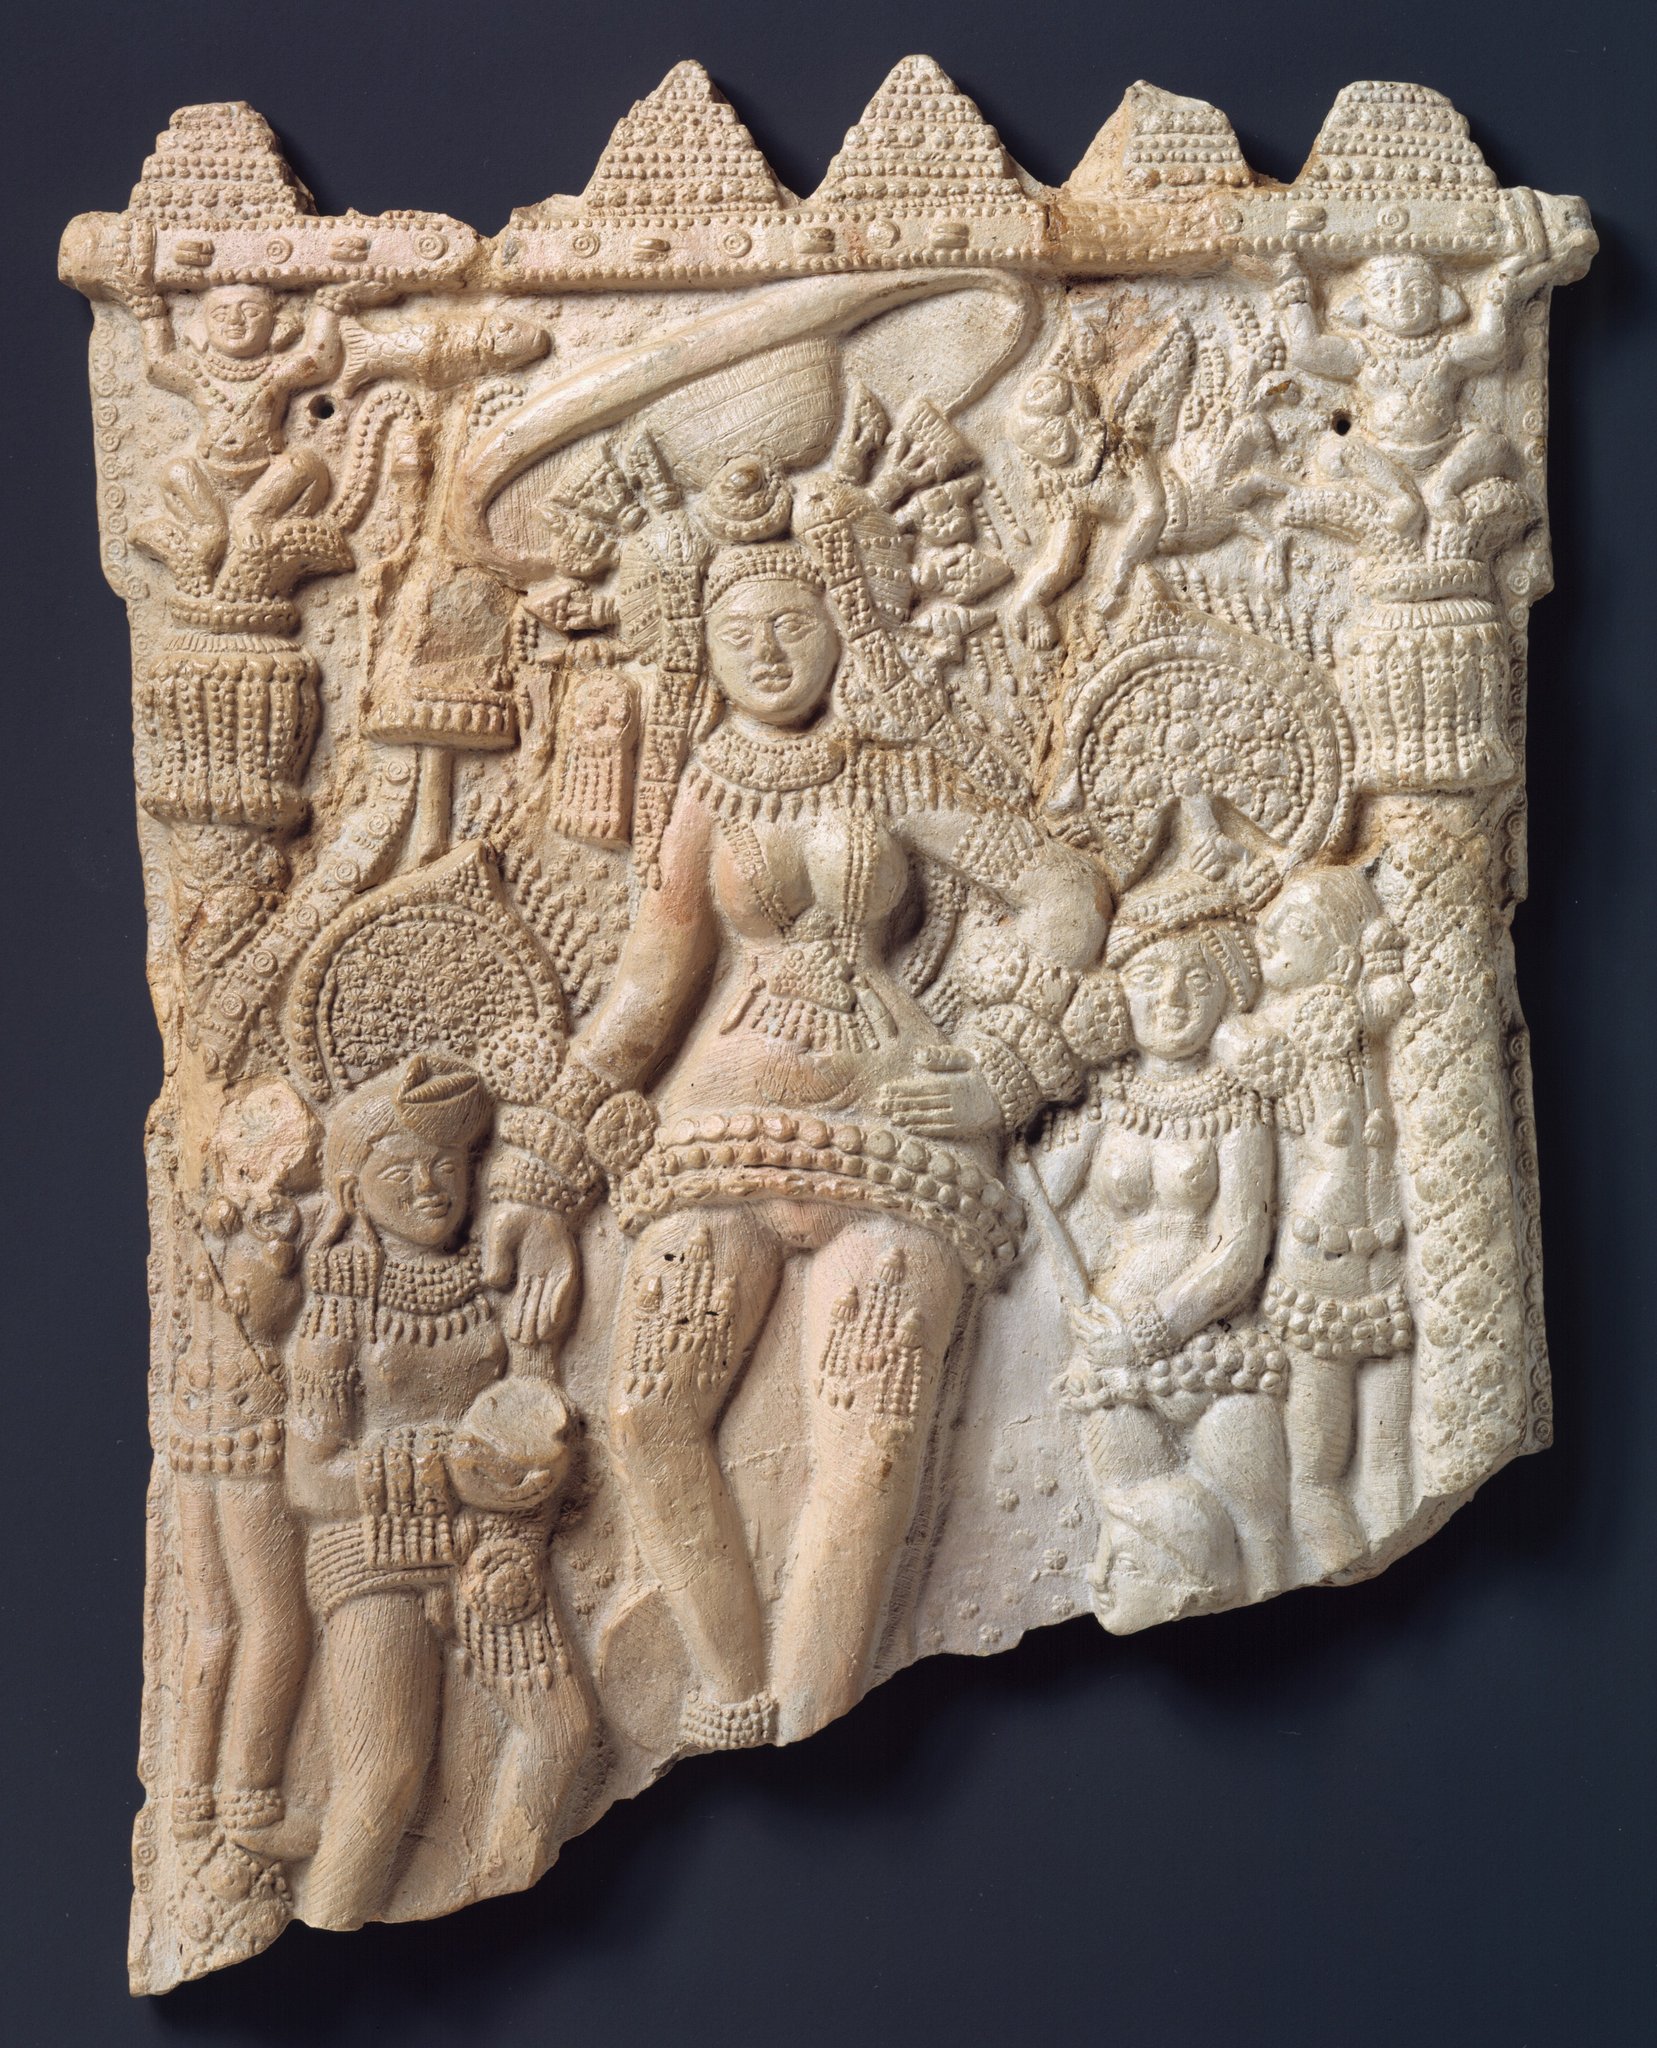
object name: plaque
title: Goddess who bestows riches, probably Sri Lakshmi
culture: indian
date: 100-1 BCE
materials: terracotta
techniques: molding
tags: female nudes,goddess